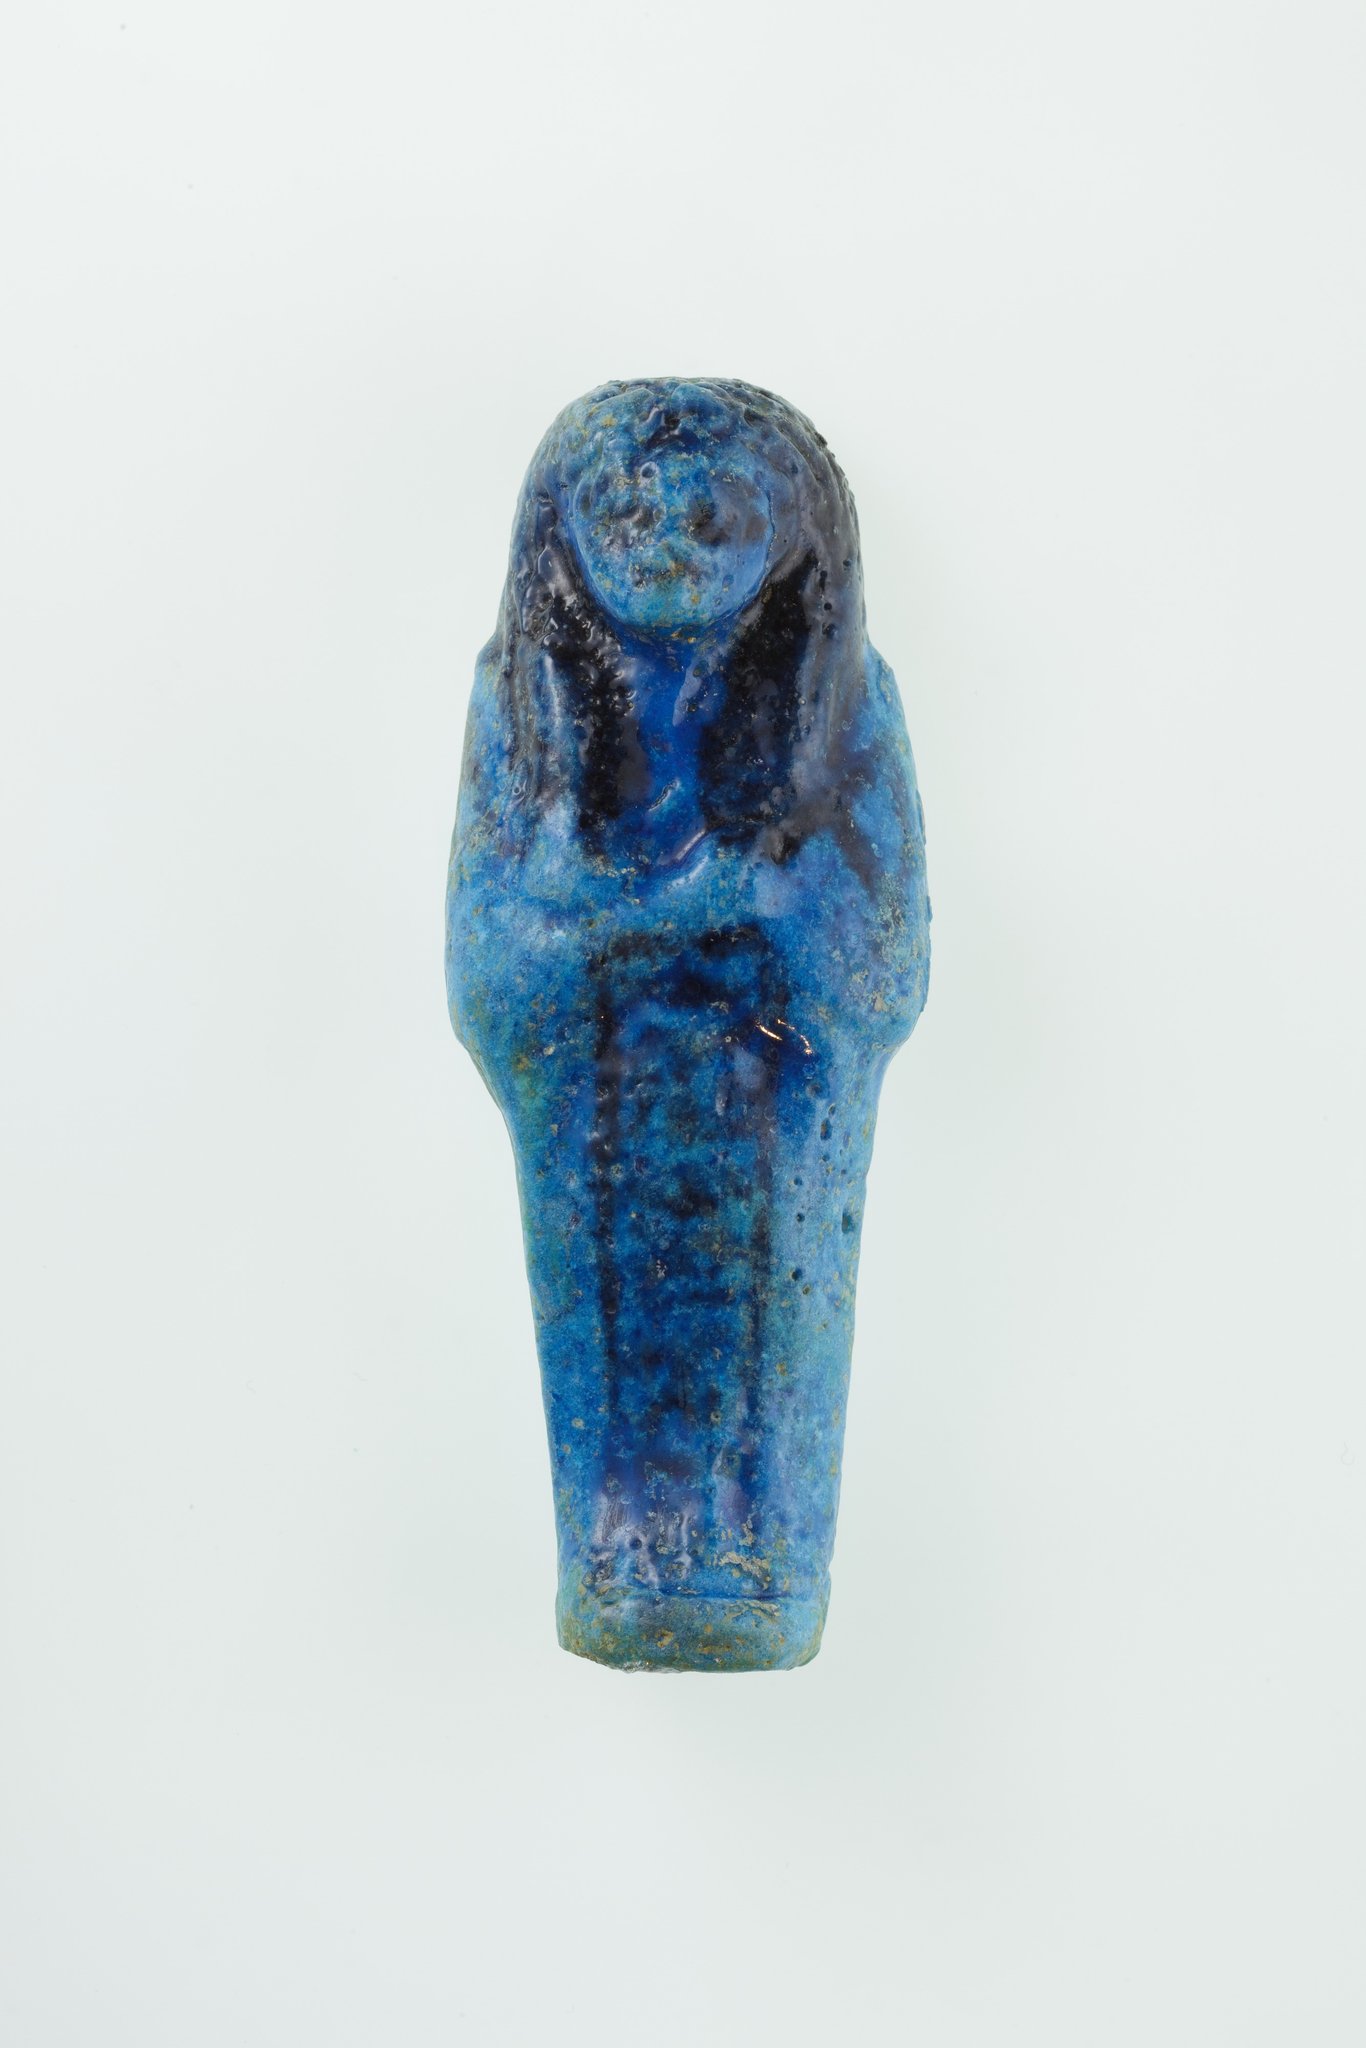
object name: shabti, worker, nauny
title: Worker Shabti of Nauny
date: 1050 BCE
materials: faience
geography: egypt